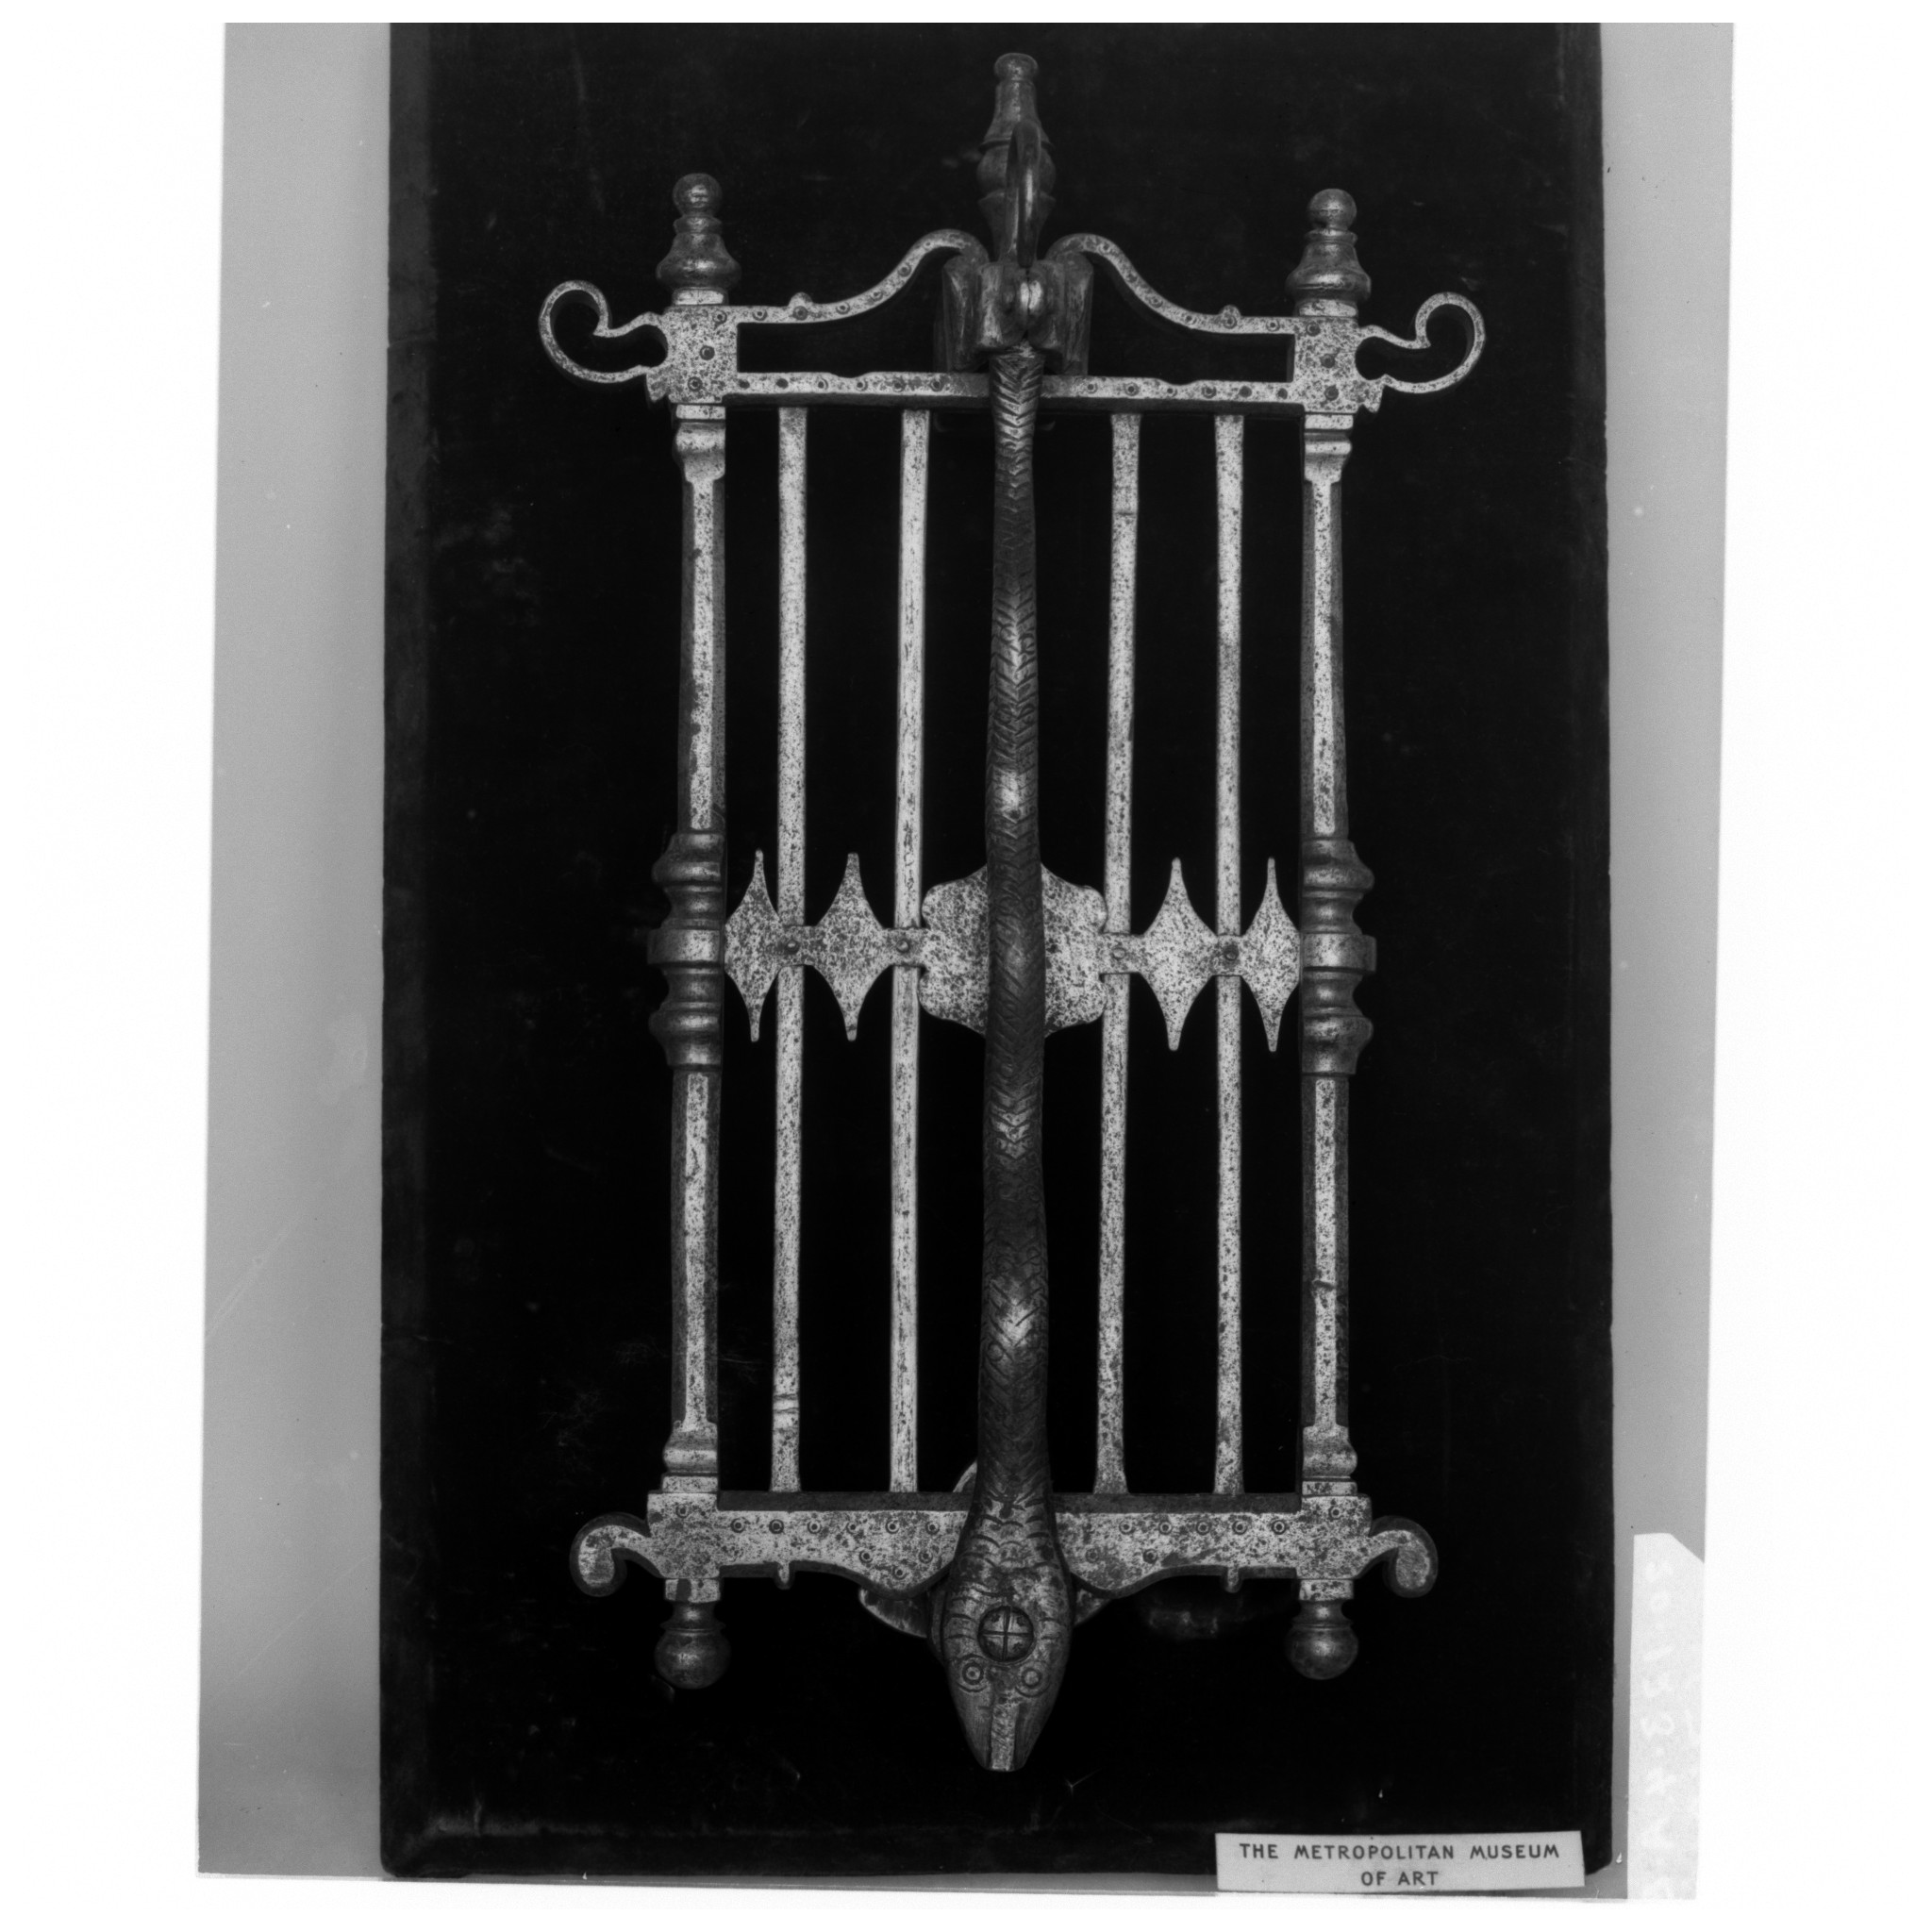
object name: door knocker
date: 1501-1600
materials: iron